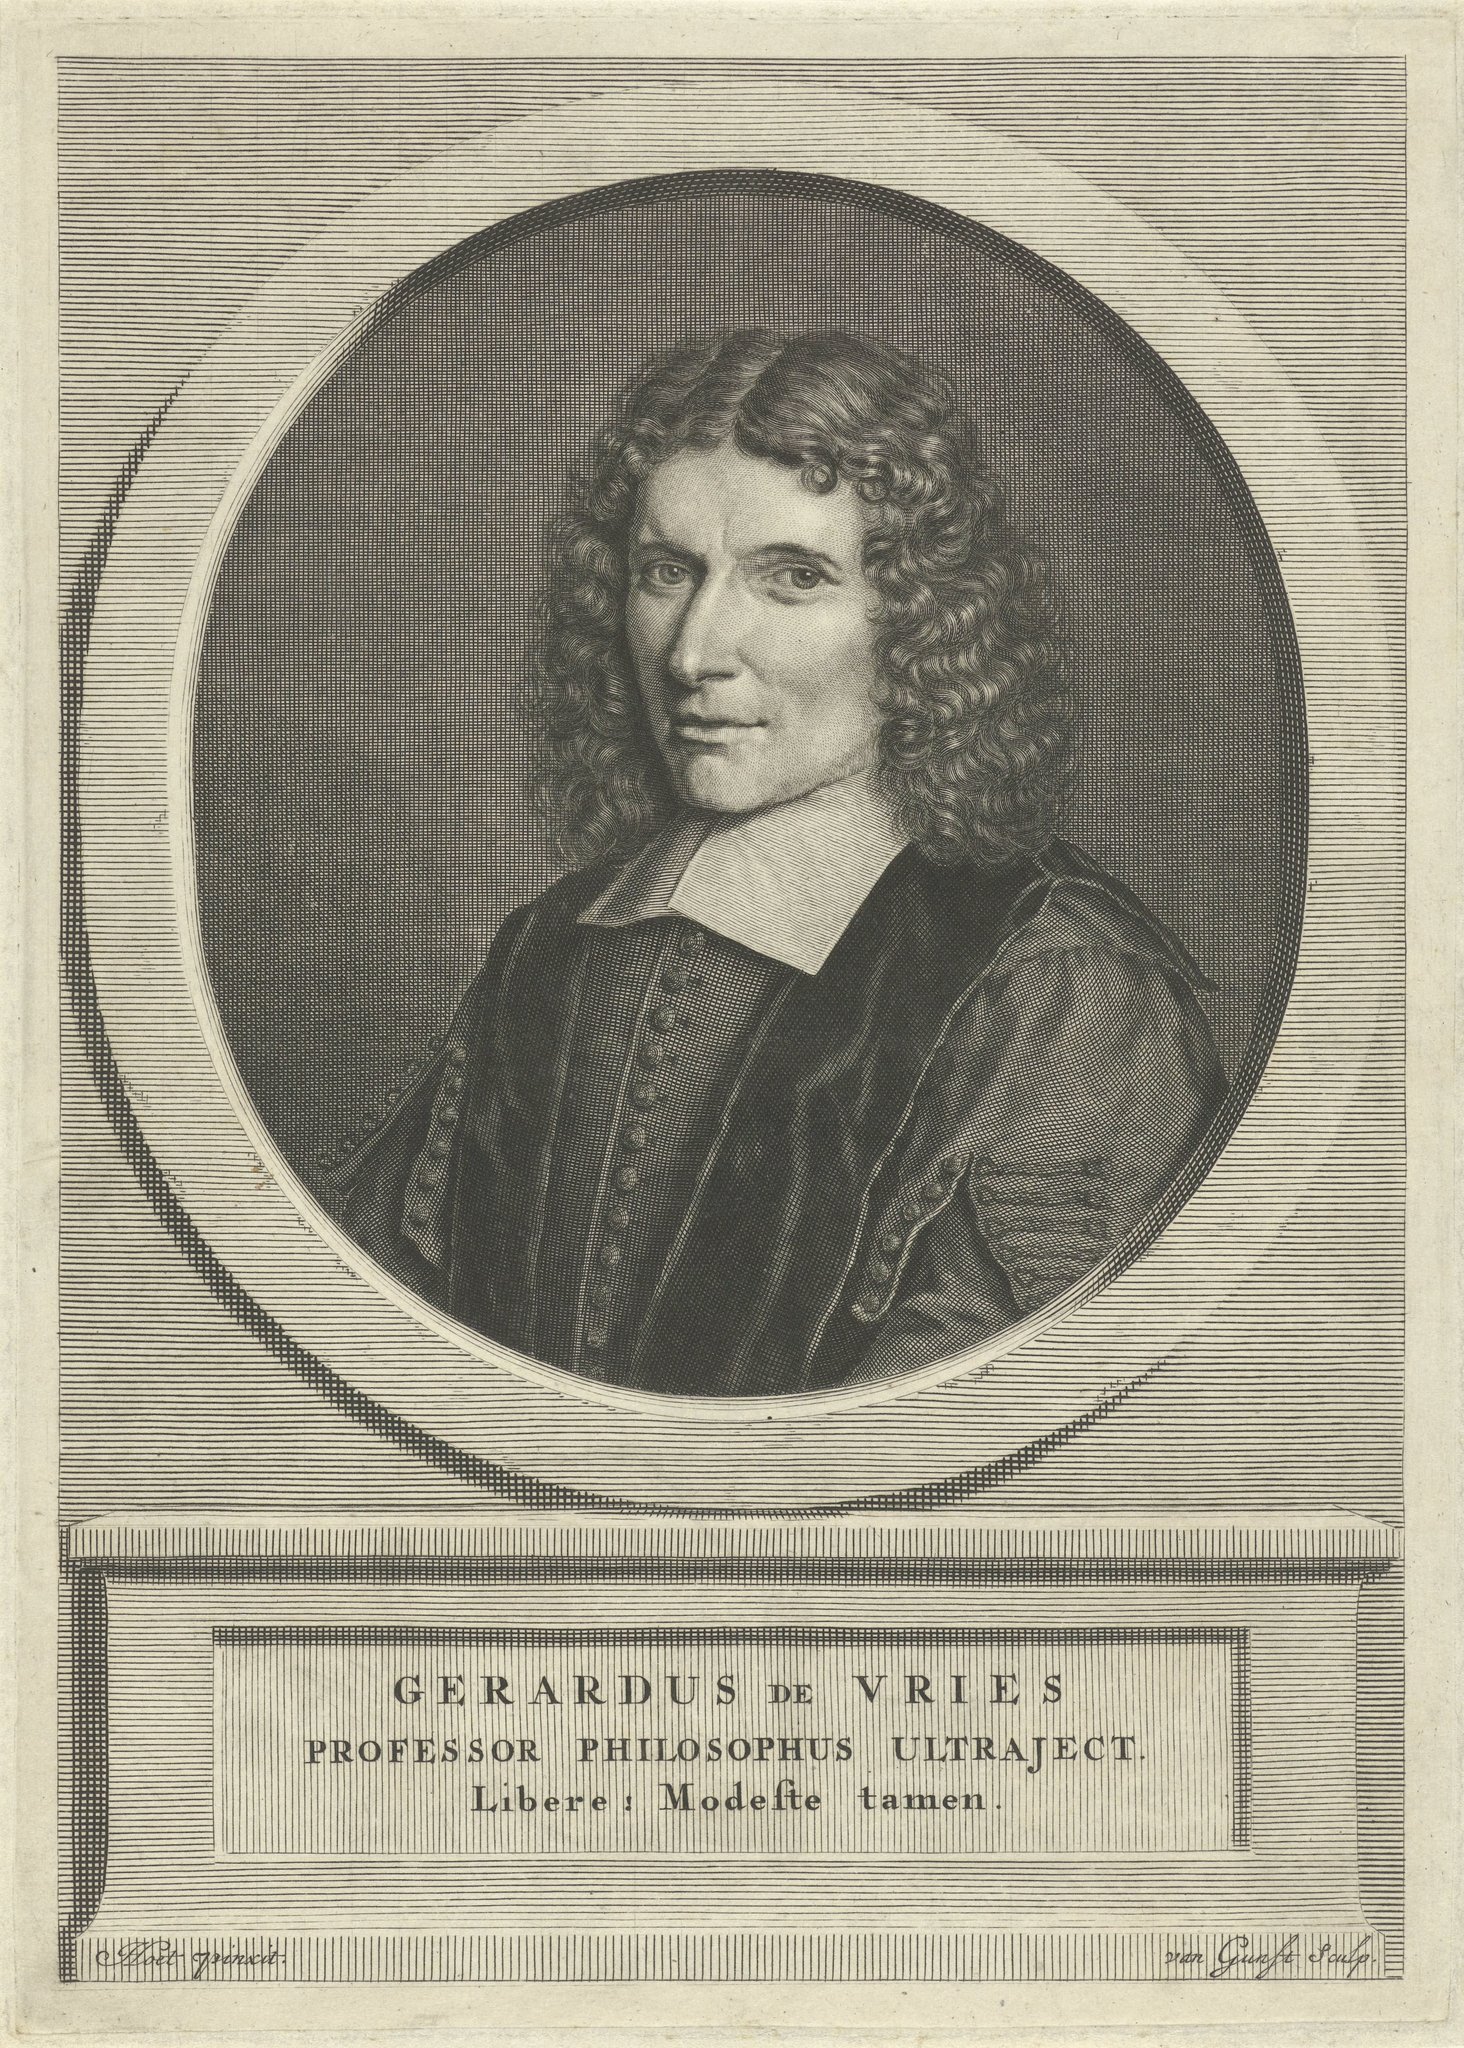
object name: print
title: Portret van Gerard de Vries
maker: pieter van gunst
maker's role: print maker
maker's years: 1658-1731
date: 1668-1731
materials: paper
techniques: engraving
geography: amsterdam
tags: gerard de vries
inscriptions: collector's mark: Lugt 2228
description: Gerard de Vries, hoogleraar filosofie te Utrecht.